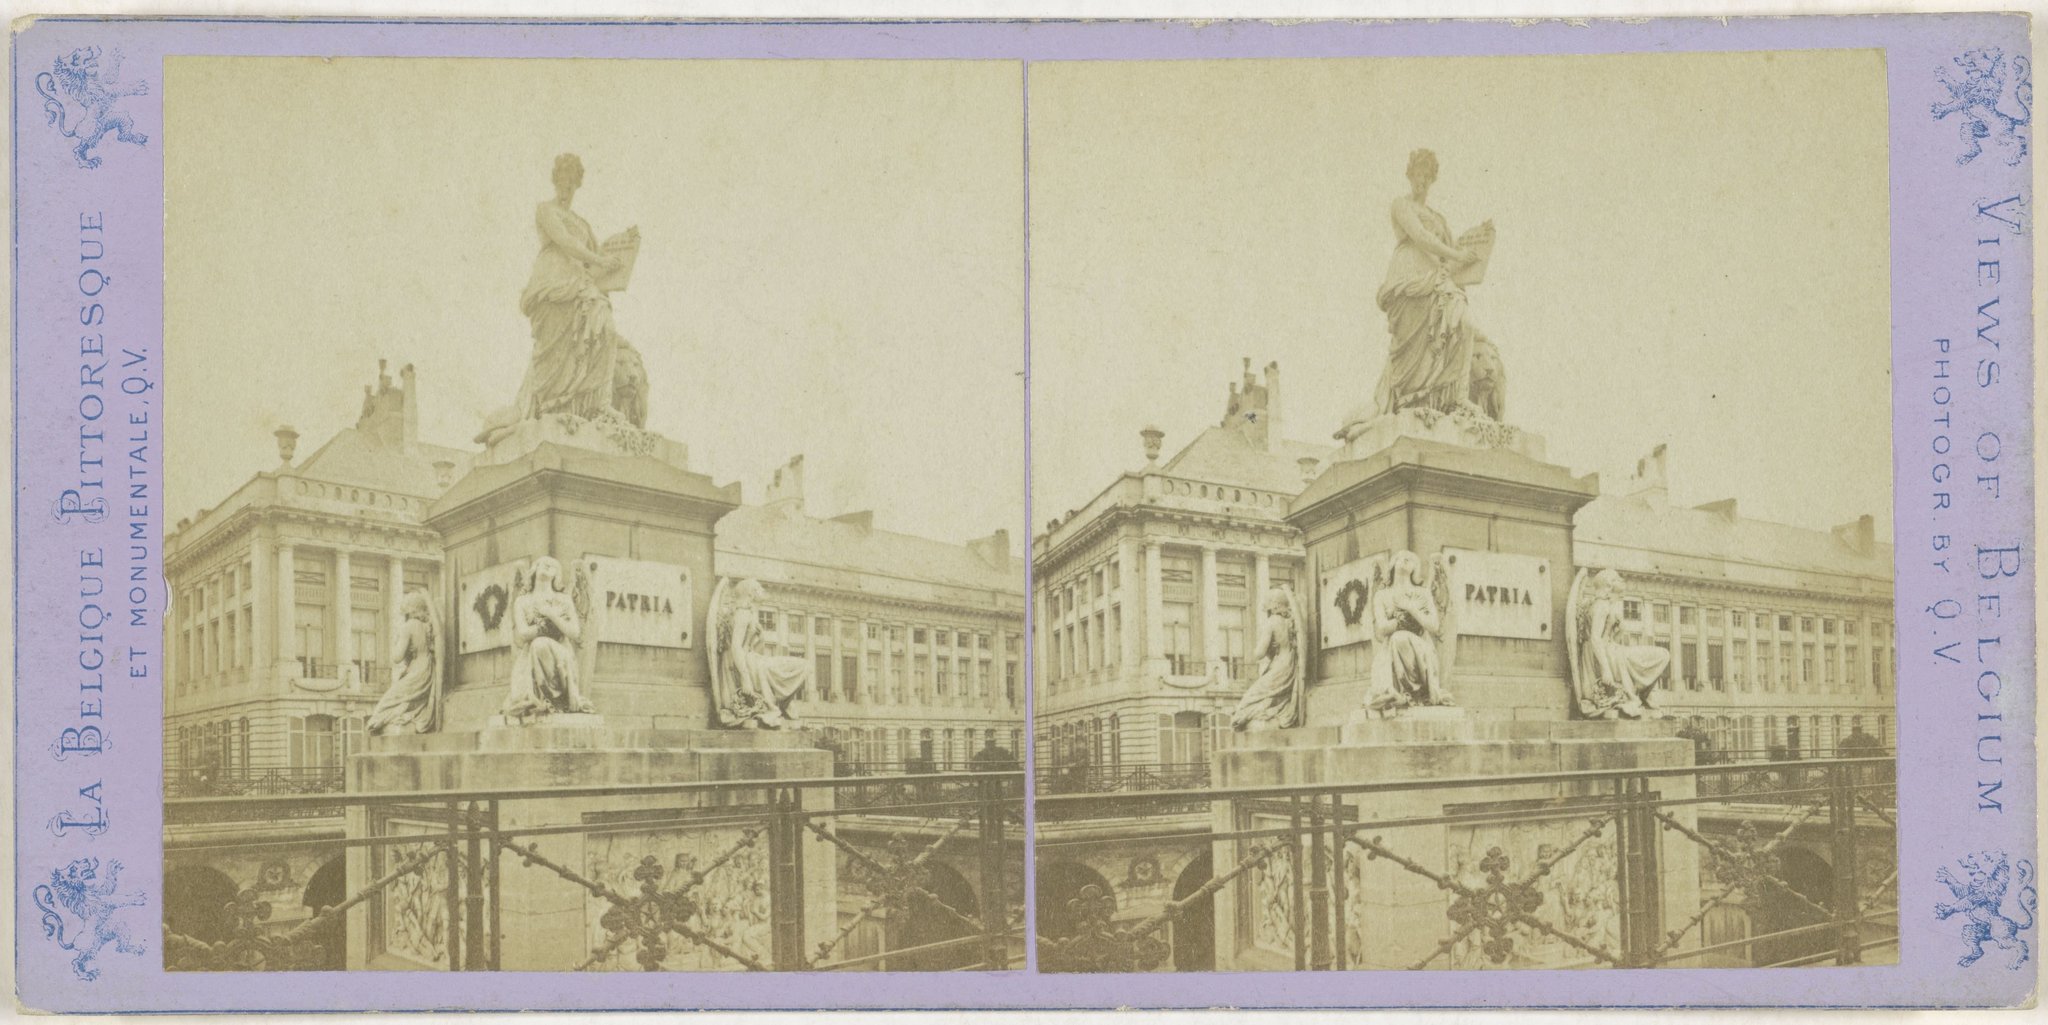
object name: stereograph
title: La Belgique pittoresque et monumentale / Views of Belgium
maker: jules hippolyte quéval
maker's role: publisher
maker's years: 1824-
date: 1866-1870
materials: cardboard, paper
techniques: albumen print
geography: brussels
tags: monument, statue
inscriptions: number: ‘No 1620’